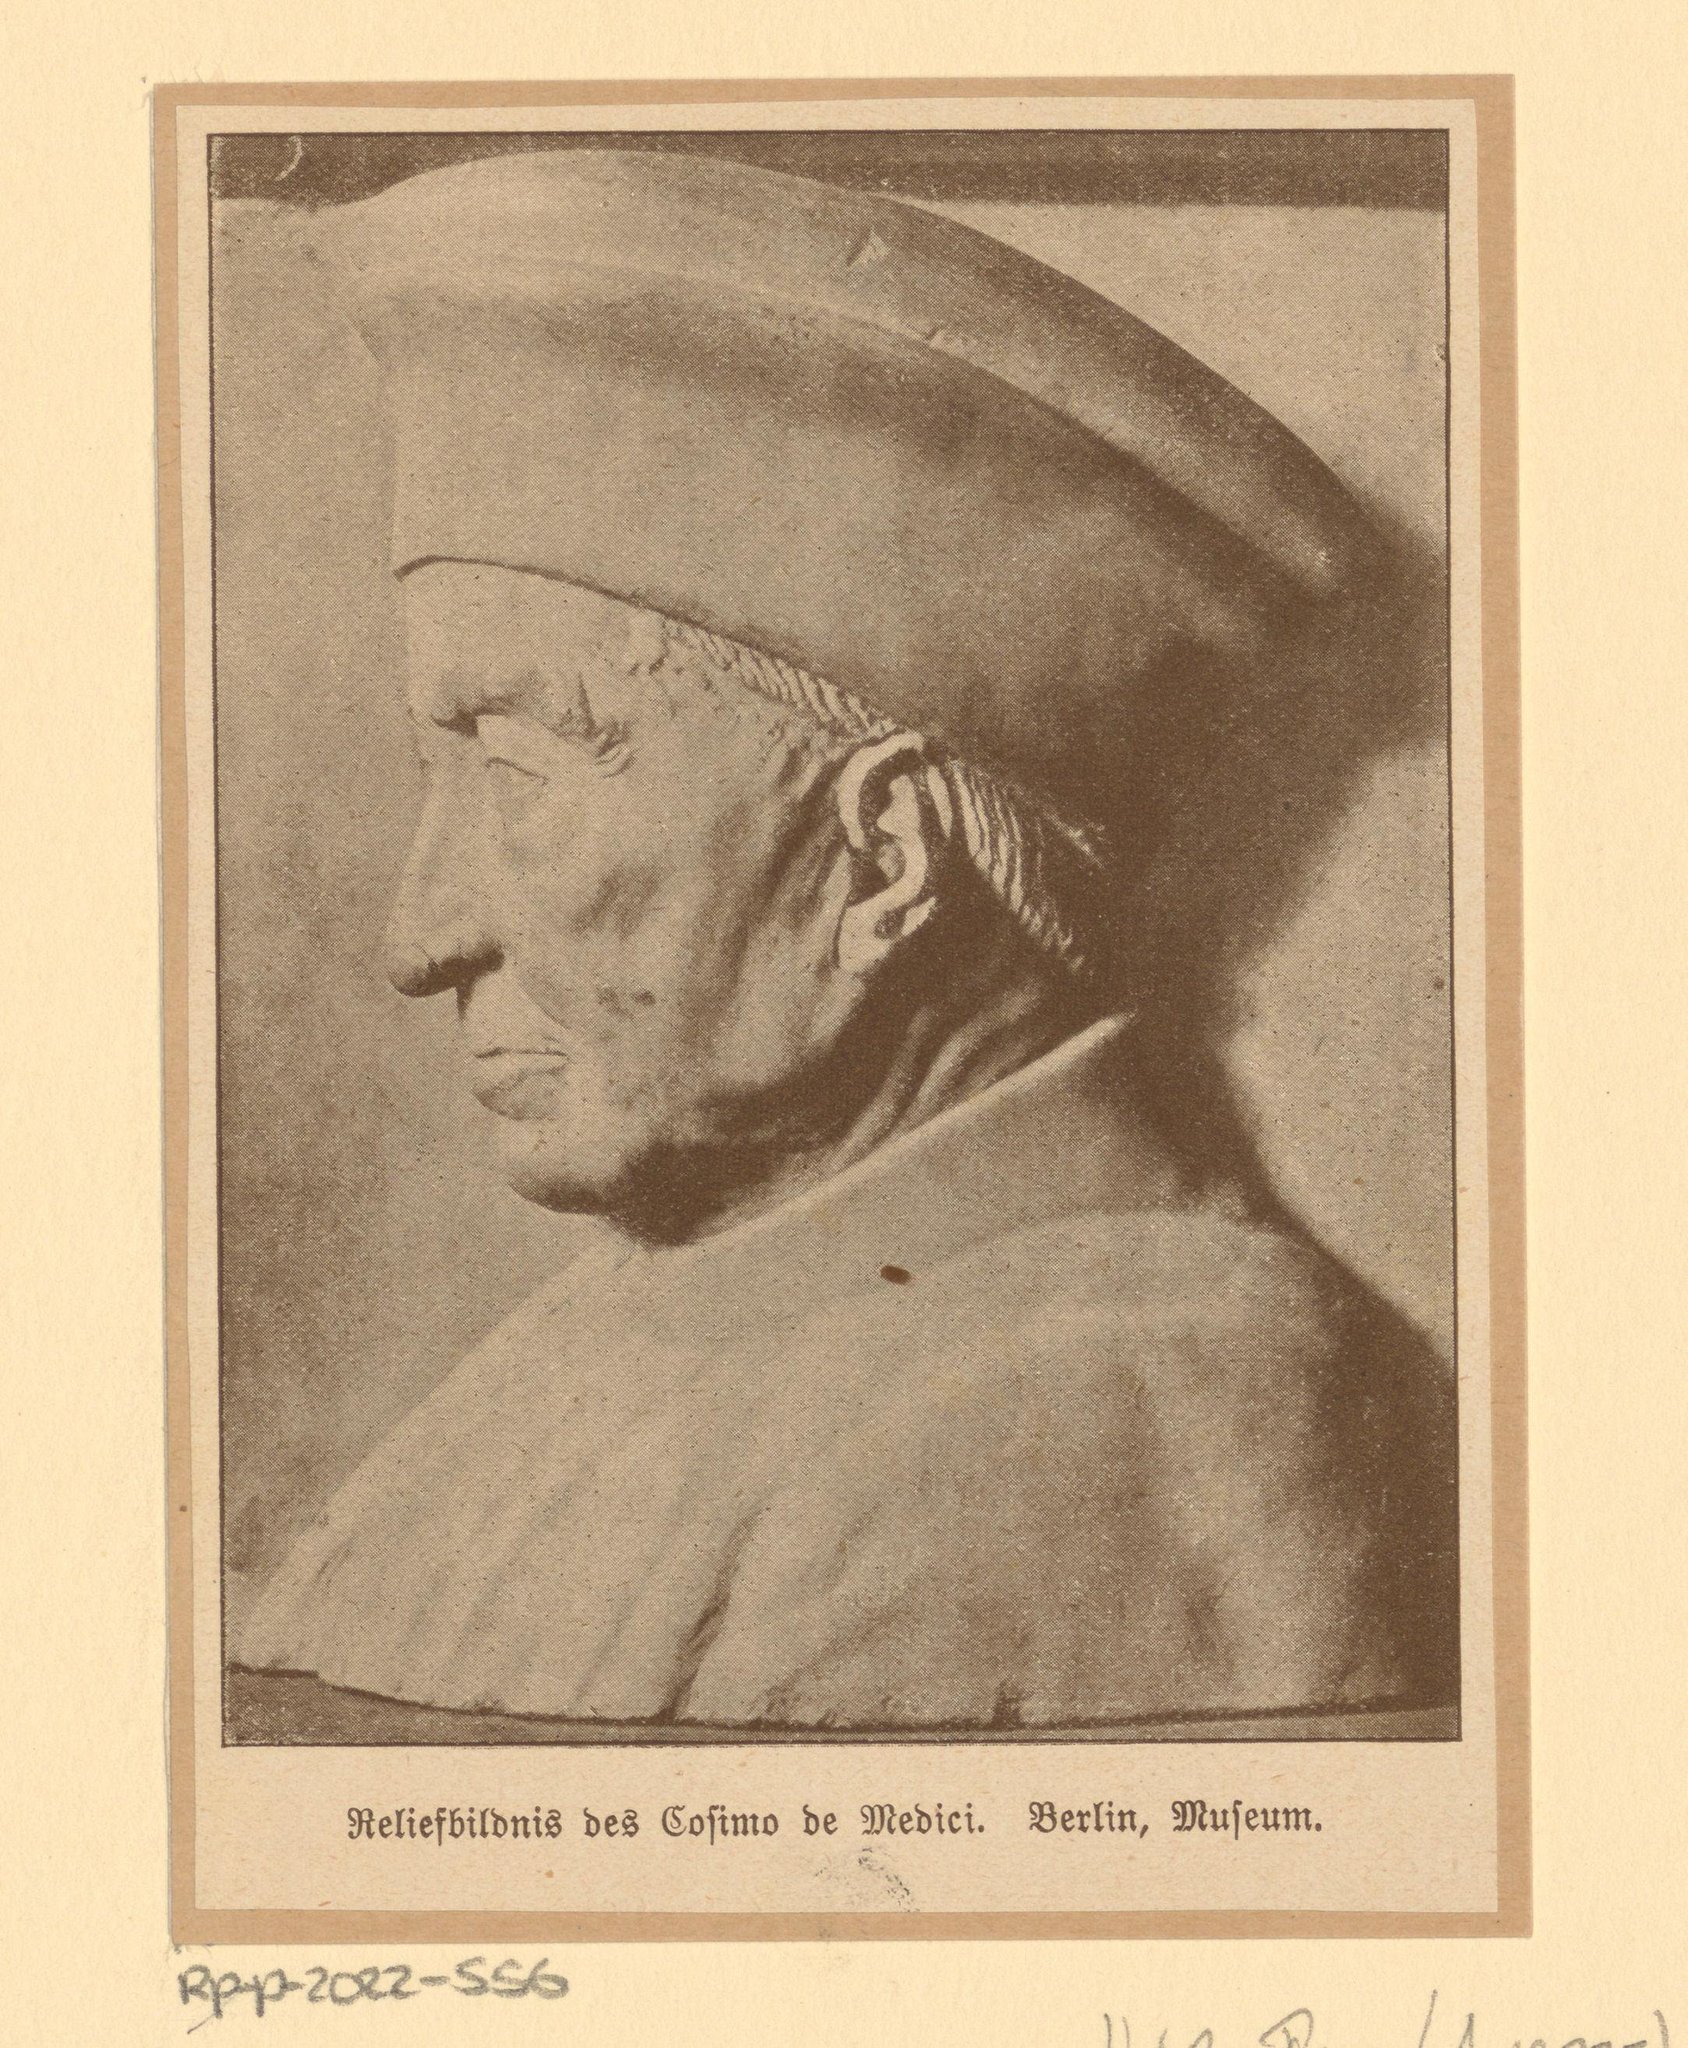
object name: photomechanical print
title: Portret van Cosimo de' Medici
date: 1882-1970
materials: paper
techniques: autotype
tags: politician, historical persons